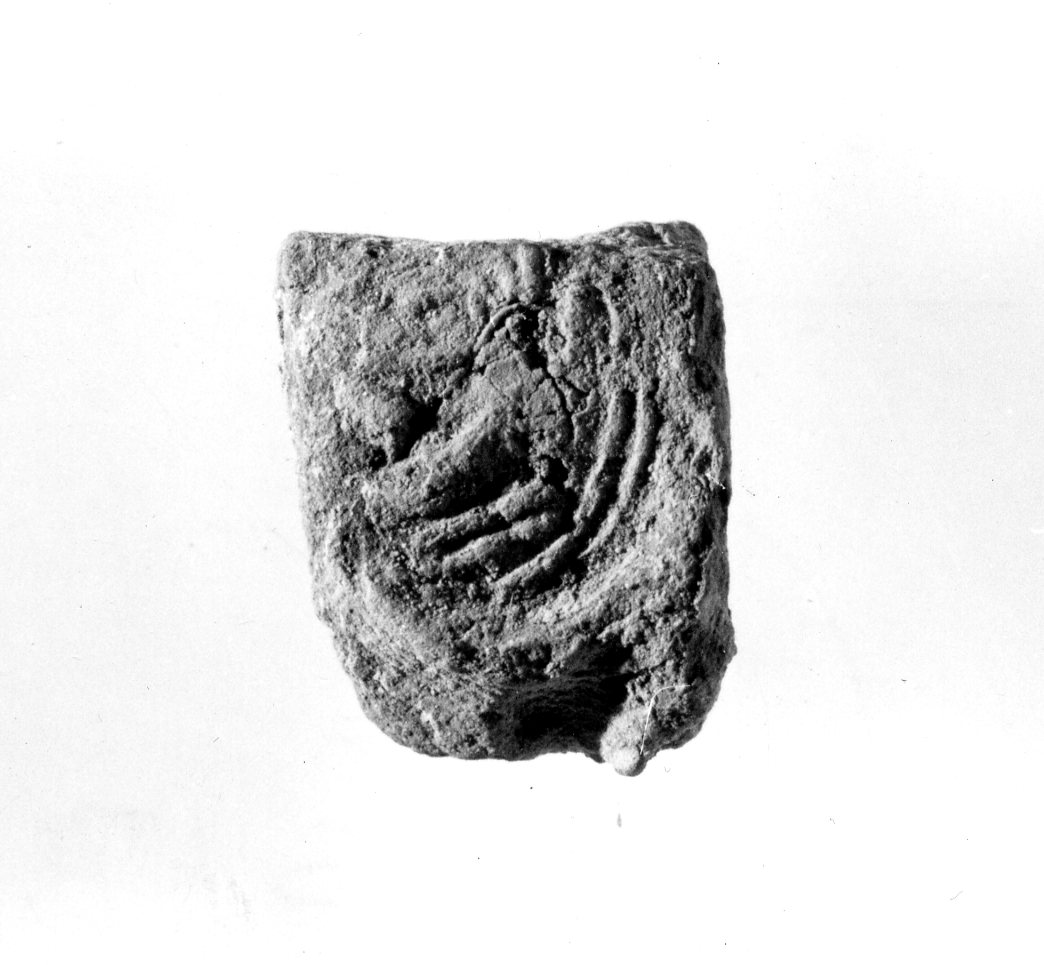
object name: sealing, amenhotep iii, nebmaatre. winged cobra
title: Document Sealing with the Throne Name of Amenhotep III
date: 1390-1352 BCE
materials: mud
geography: egypt